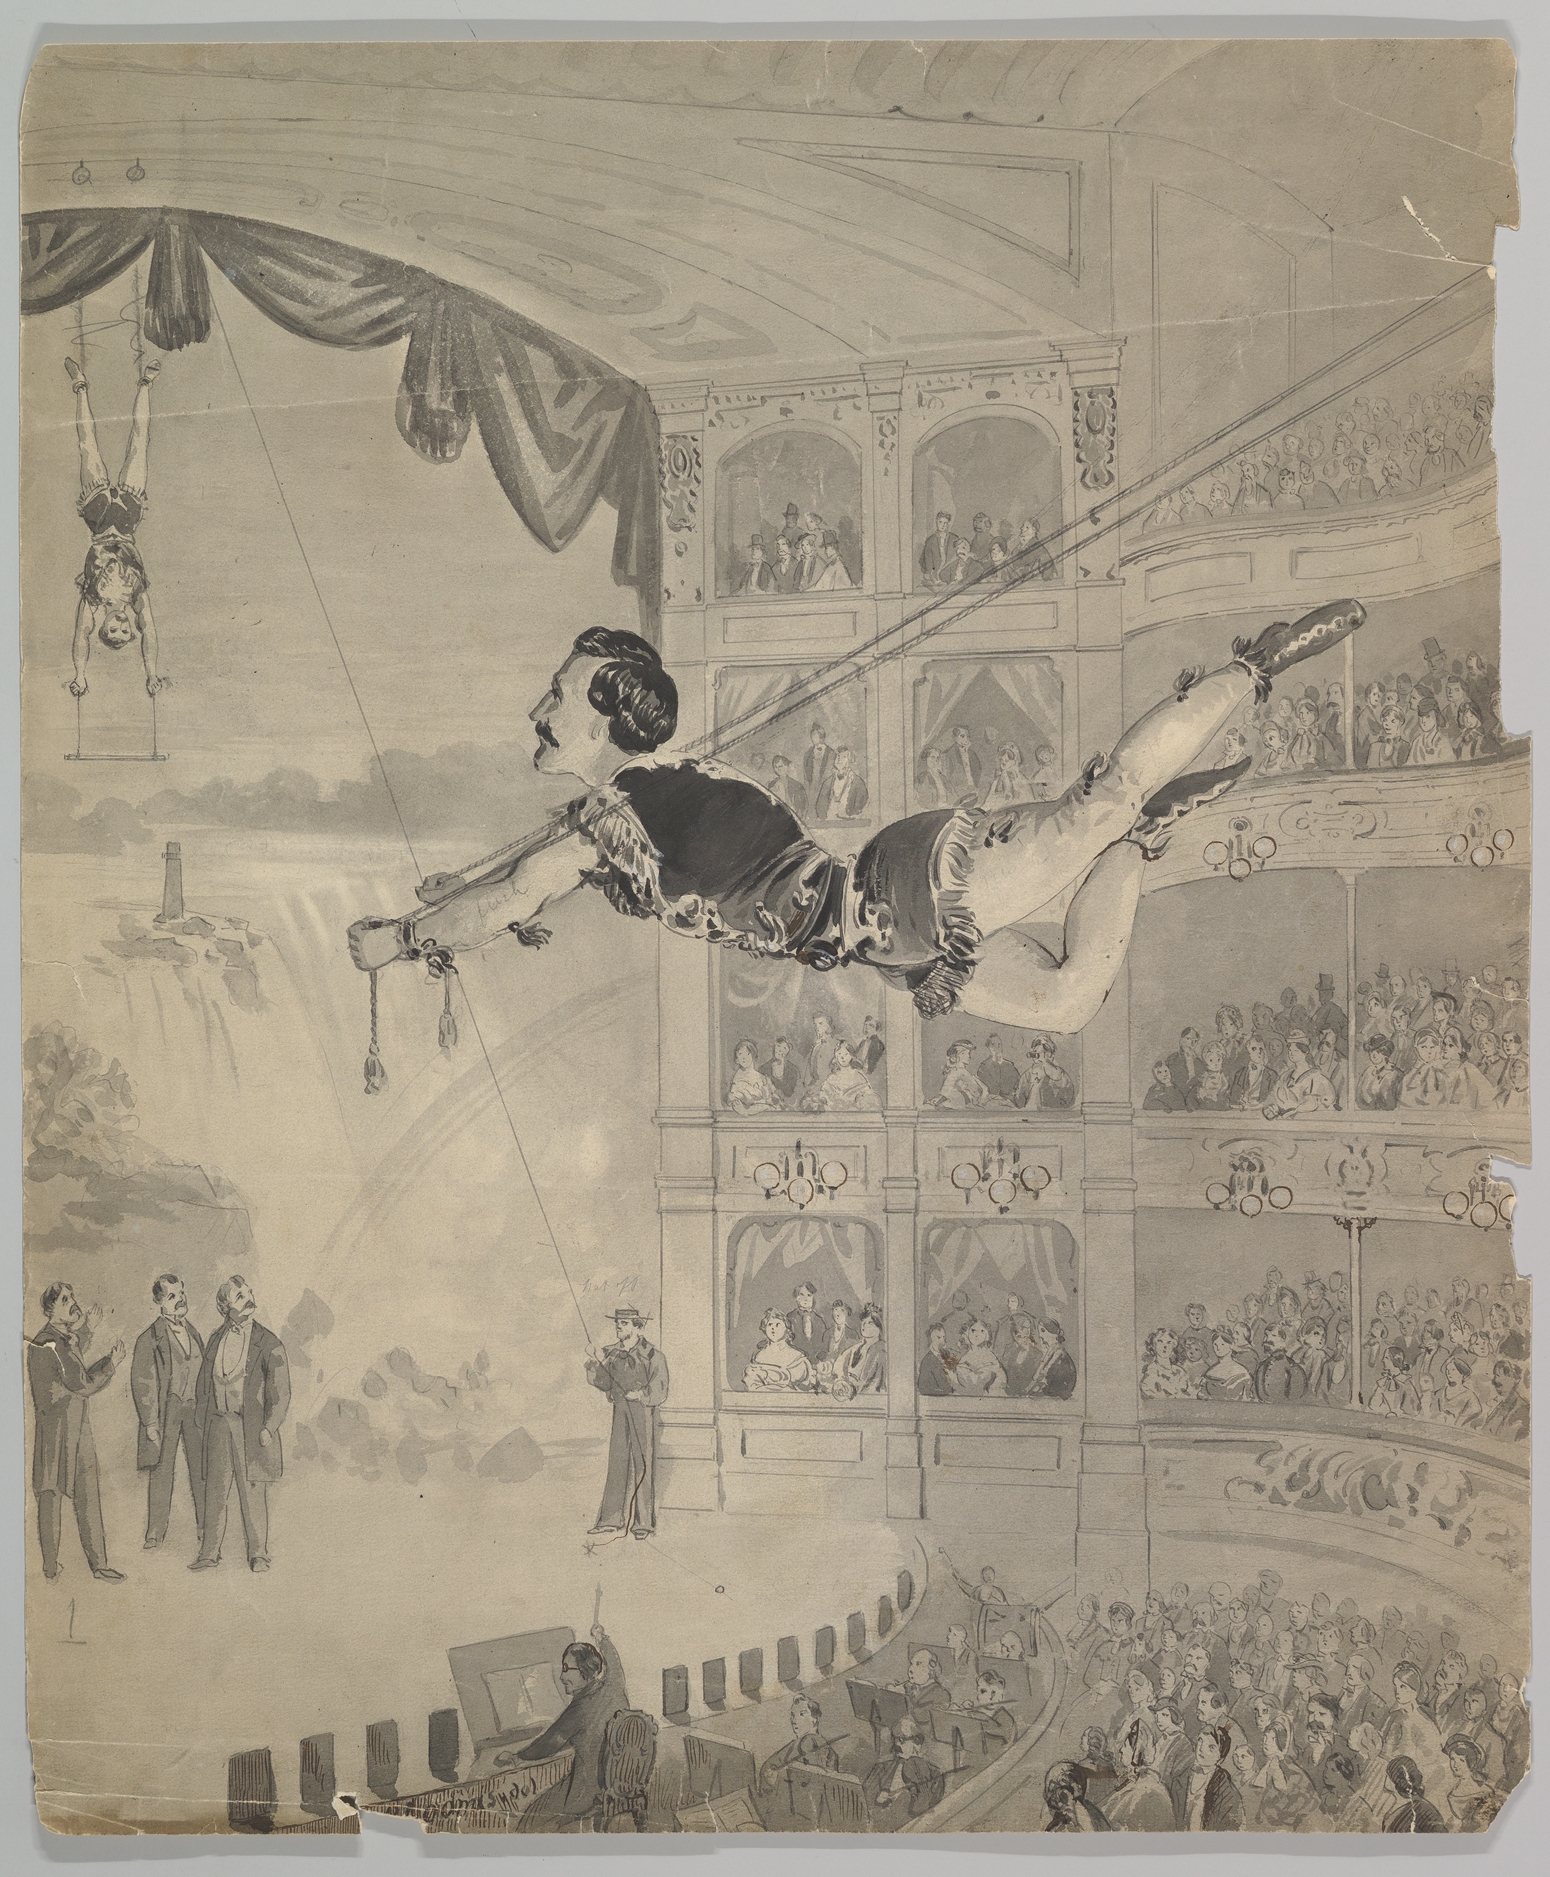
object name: drawing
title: Trapeze Artist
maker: anonymous, british, 19th century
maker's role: artist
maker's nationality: british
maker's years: 1800-1900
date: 1867-1900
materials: gouache, ink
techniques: brush, pen, wash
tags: theatre,men,spectators,acrobats